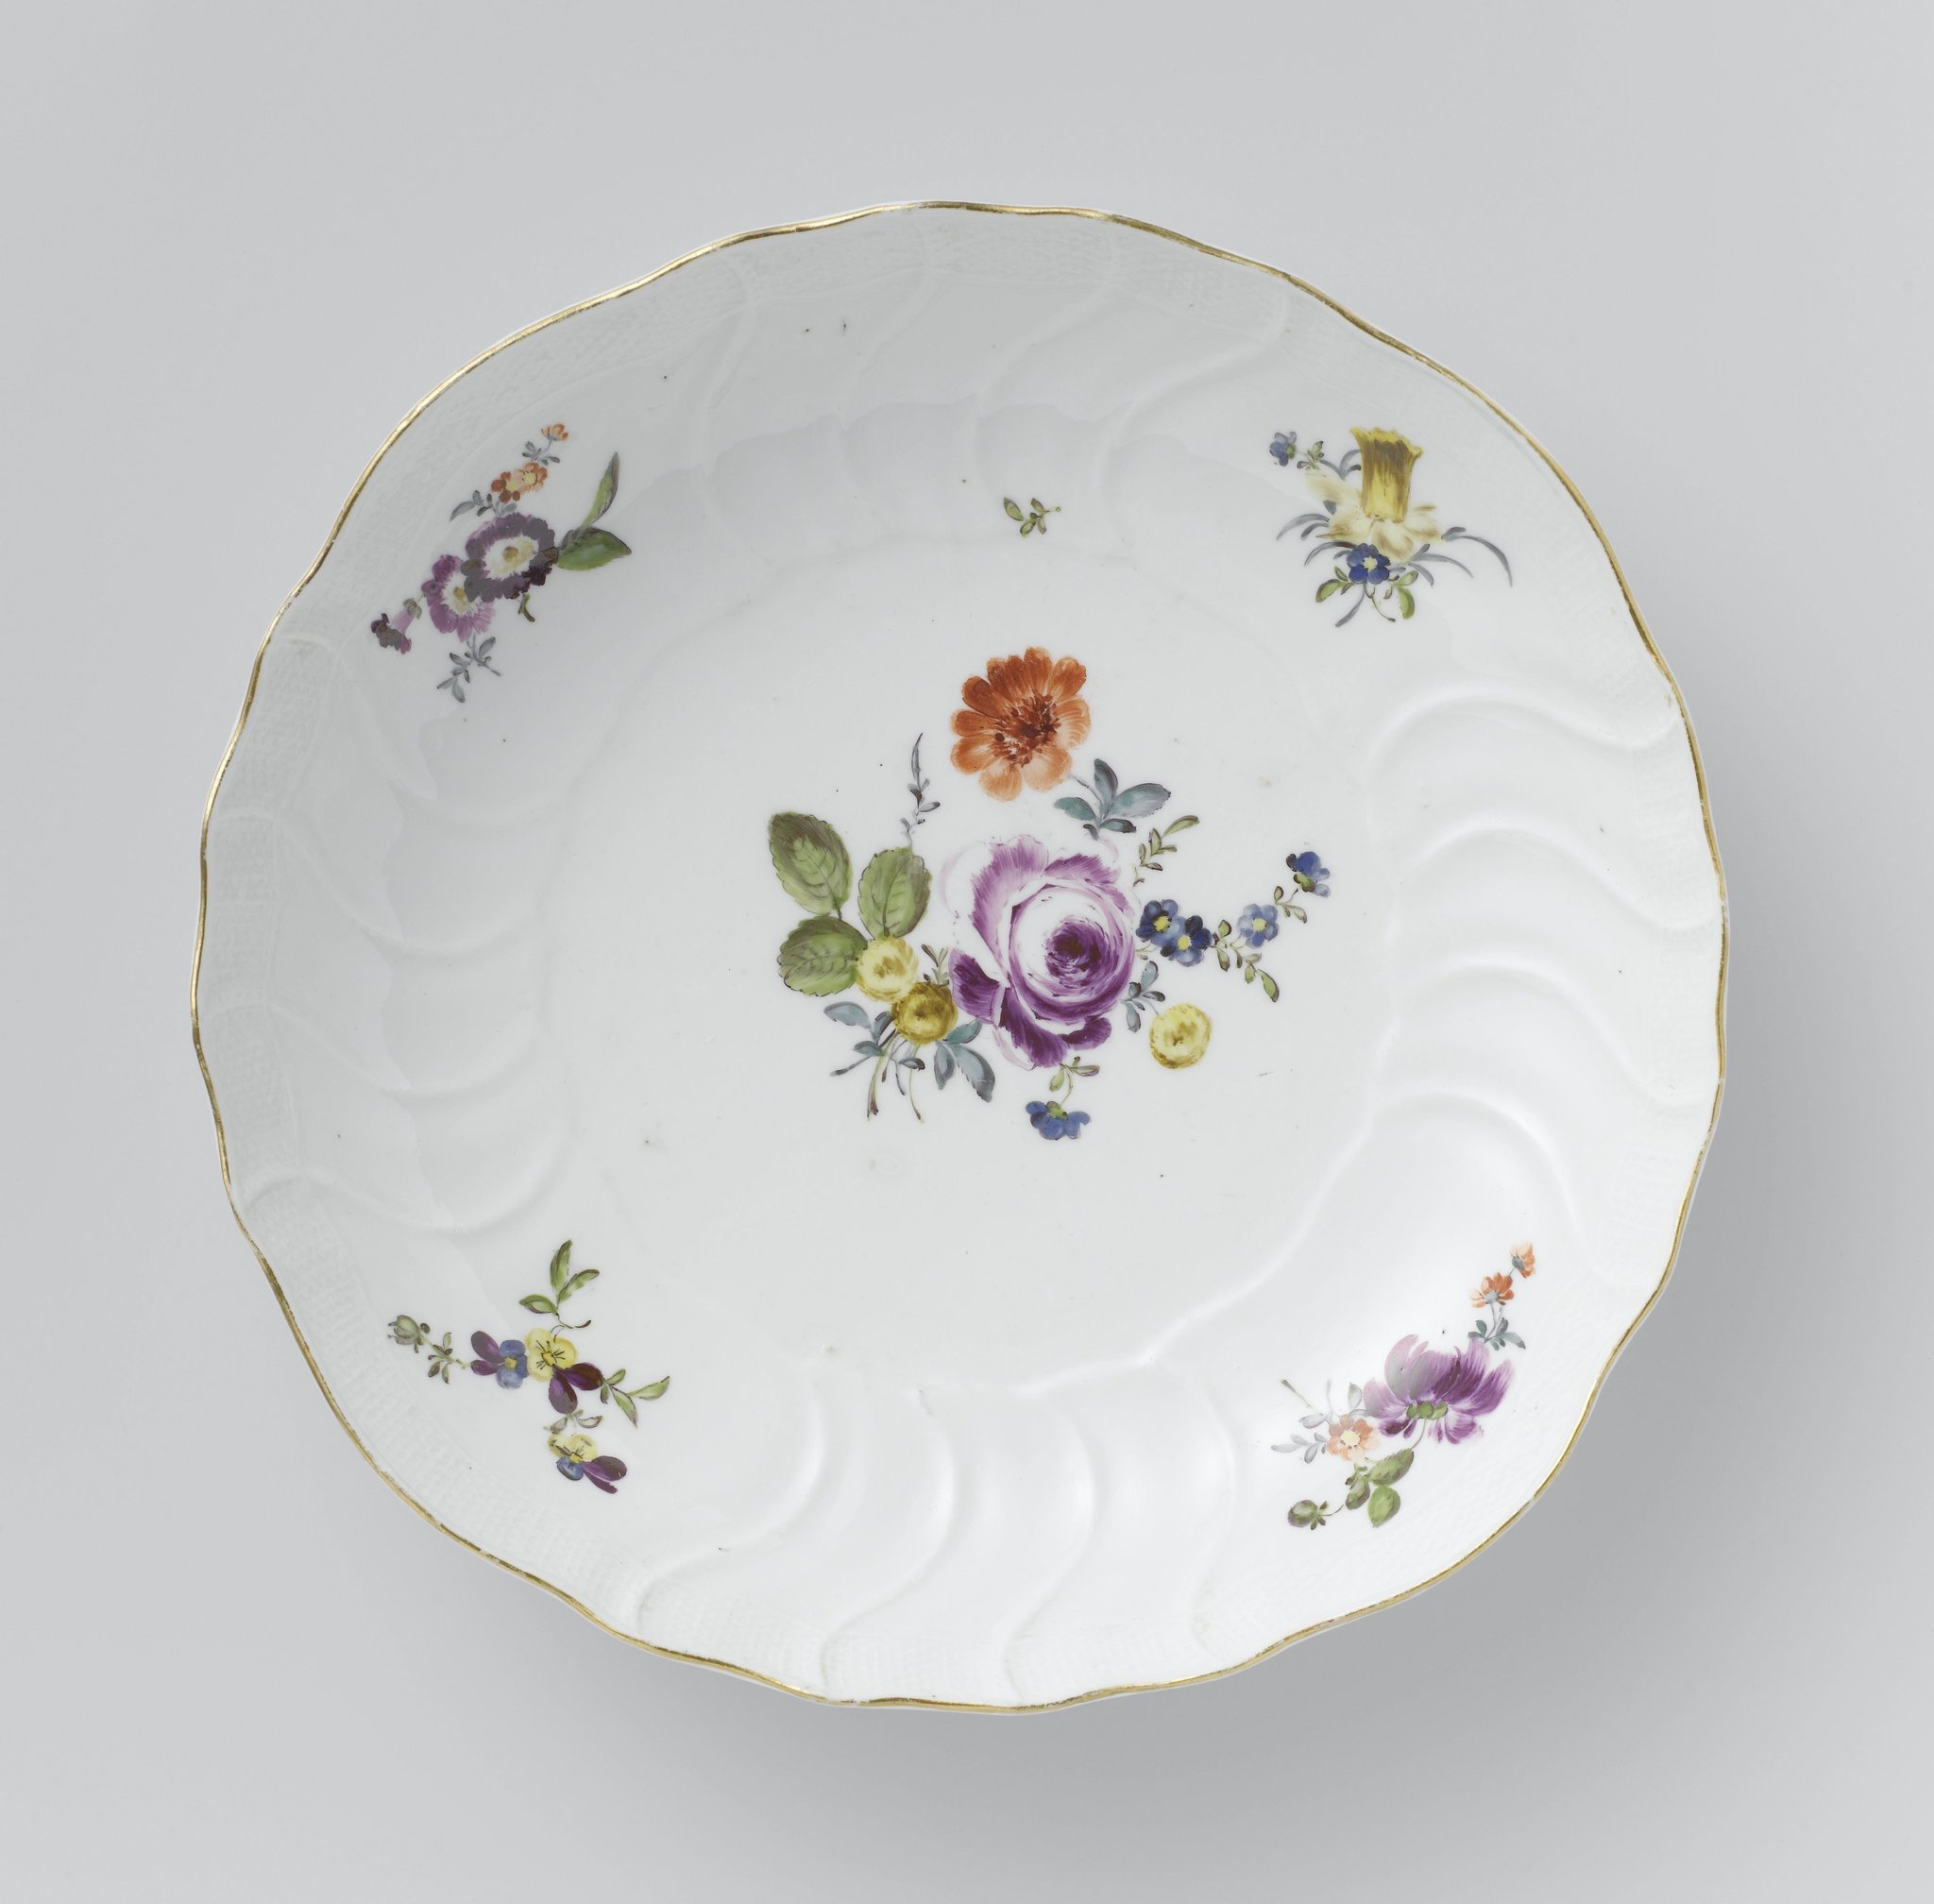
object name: platter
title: Schotel, veelkleurig beschilderd met Deutsche Blumen, insekten en vruchten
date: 1750-1760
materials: porcelain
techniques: painted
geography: meissen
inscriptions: factory mark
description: Ronde schotel van beschilderd porselein. De schotel is beschilderd met Deutsche Blumen, insekten en vruchten. De rand is in reliëf versierd met het Neuozier-patroon. De schotel is gemerkt en hoort bij een servies (BK-17474-1 t/m BK-17474-253).